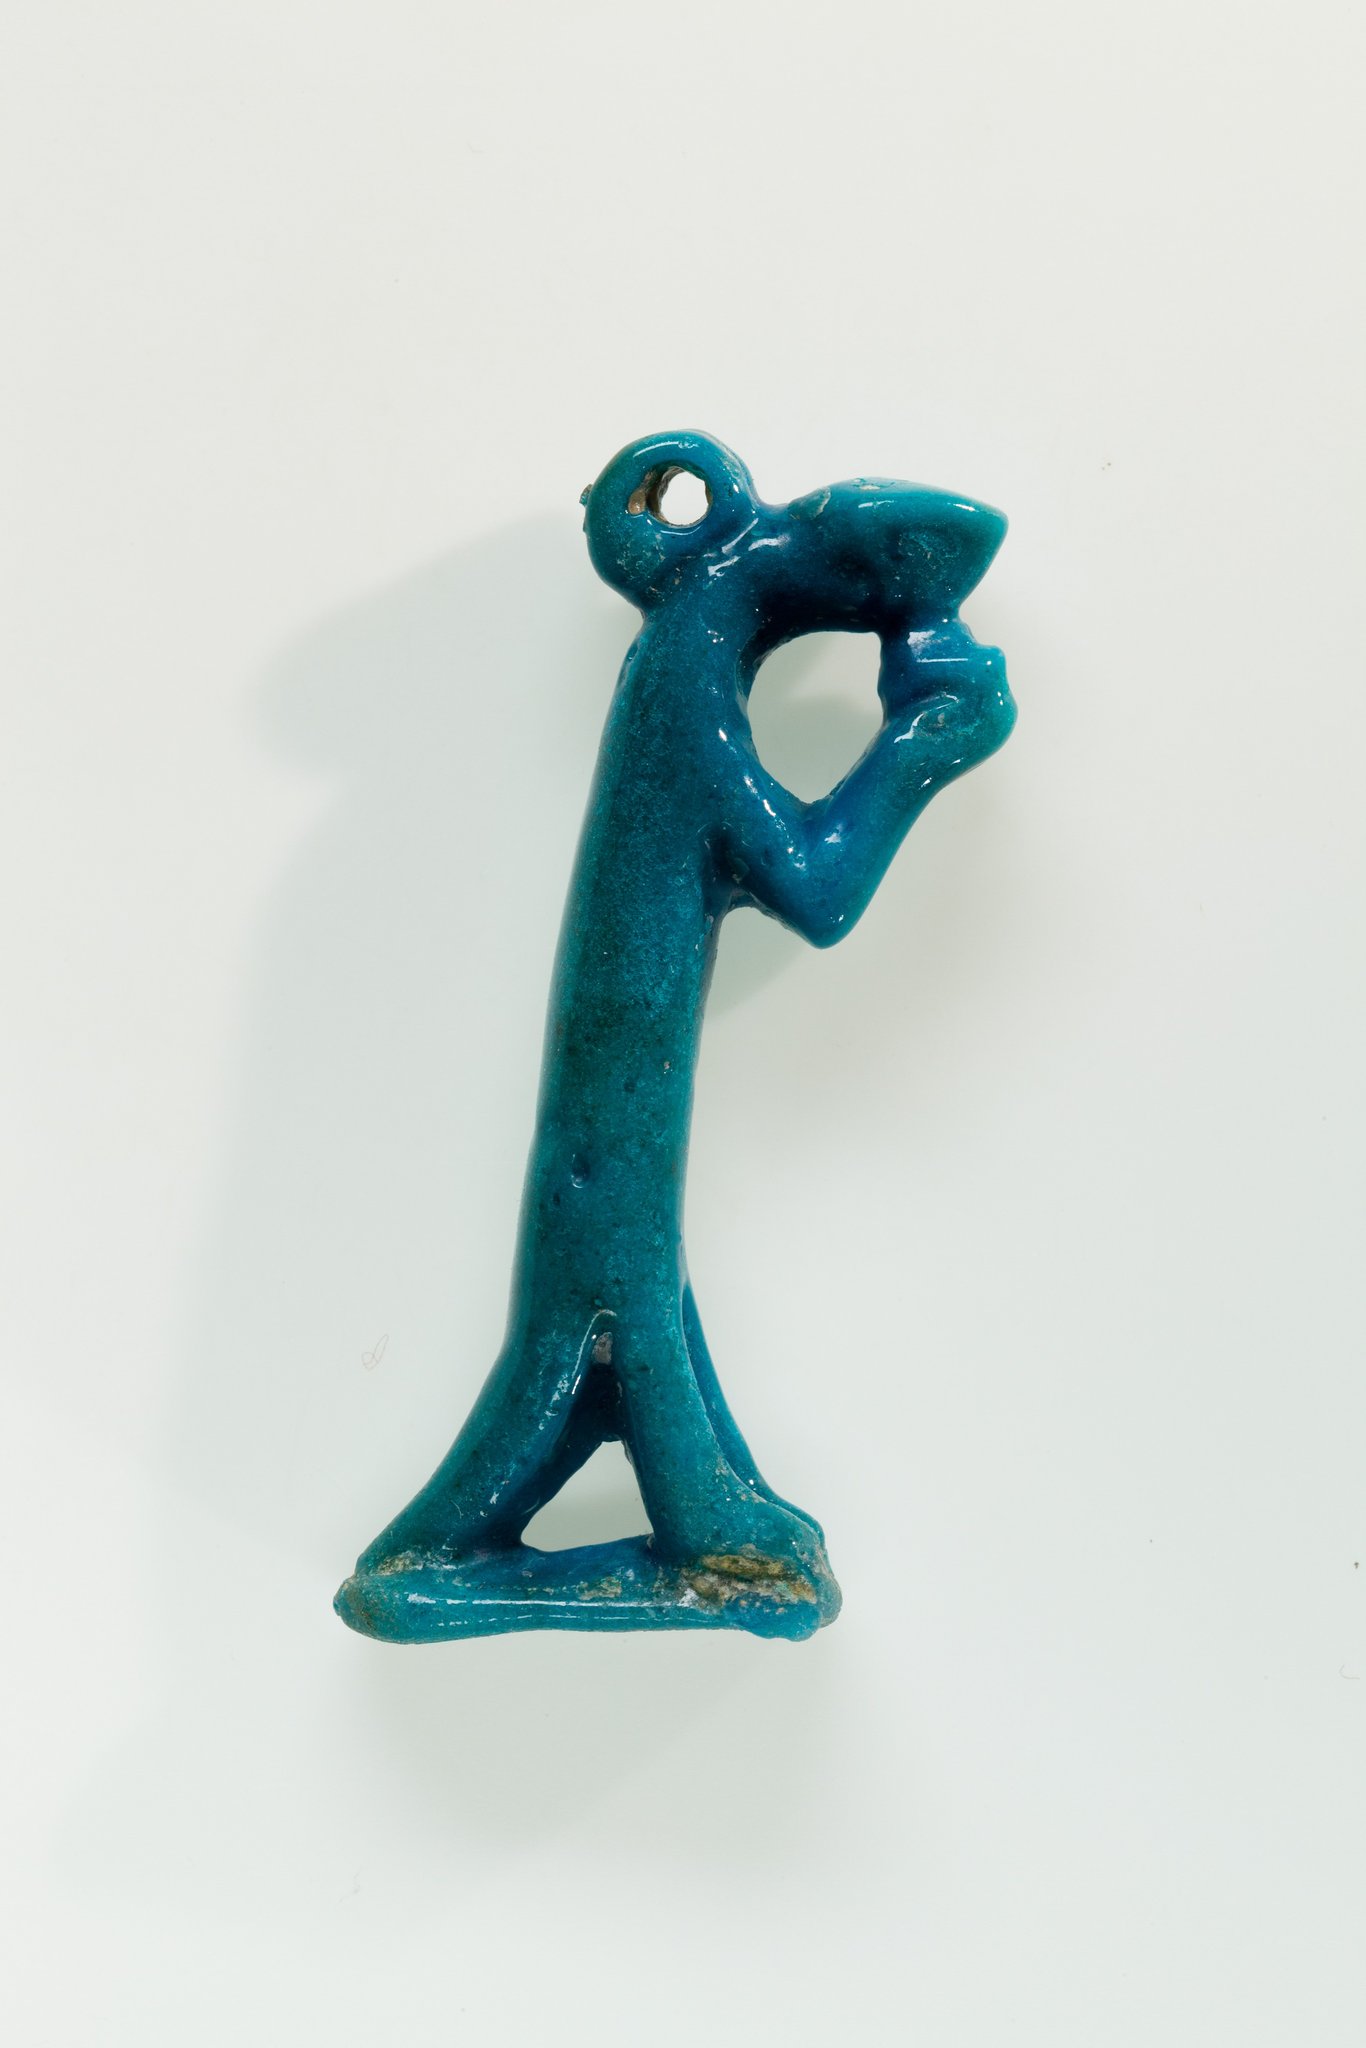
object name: amulet, nehebkau, nesenaset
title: Nehebkau amulet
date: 1070-945 BCE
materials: faience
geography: egypt